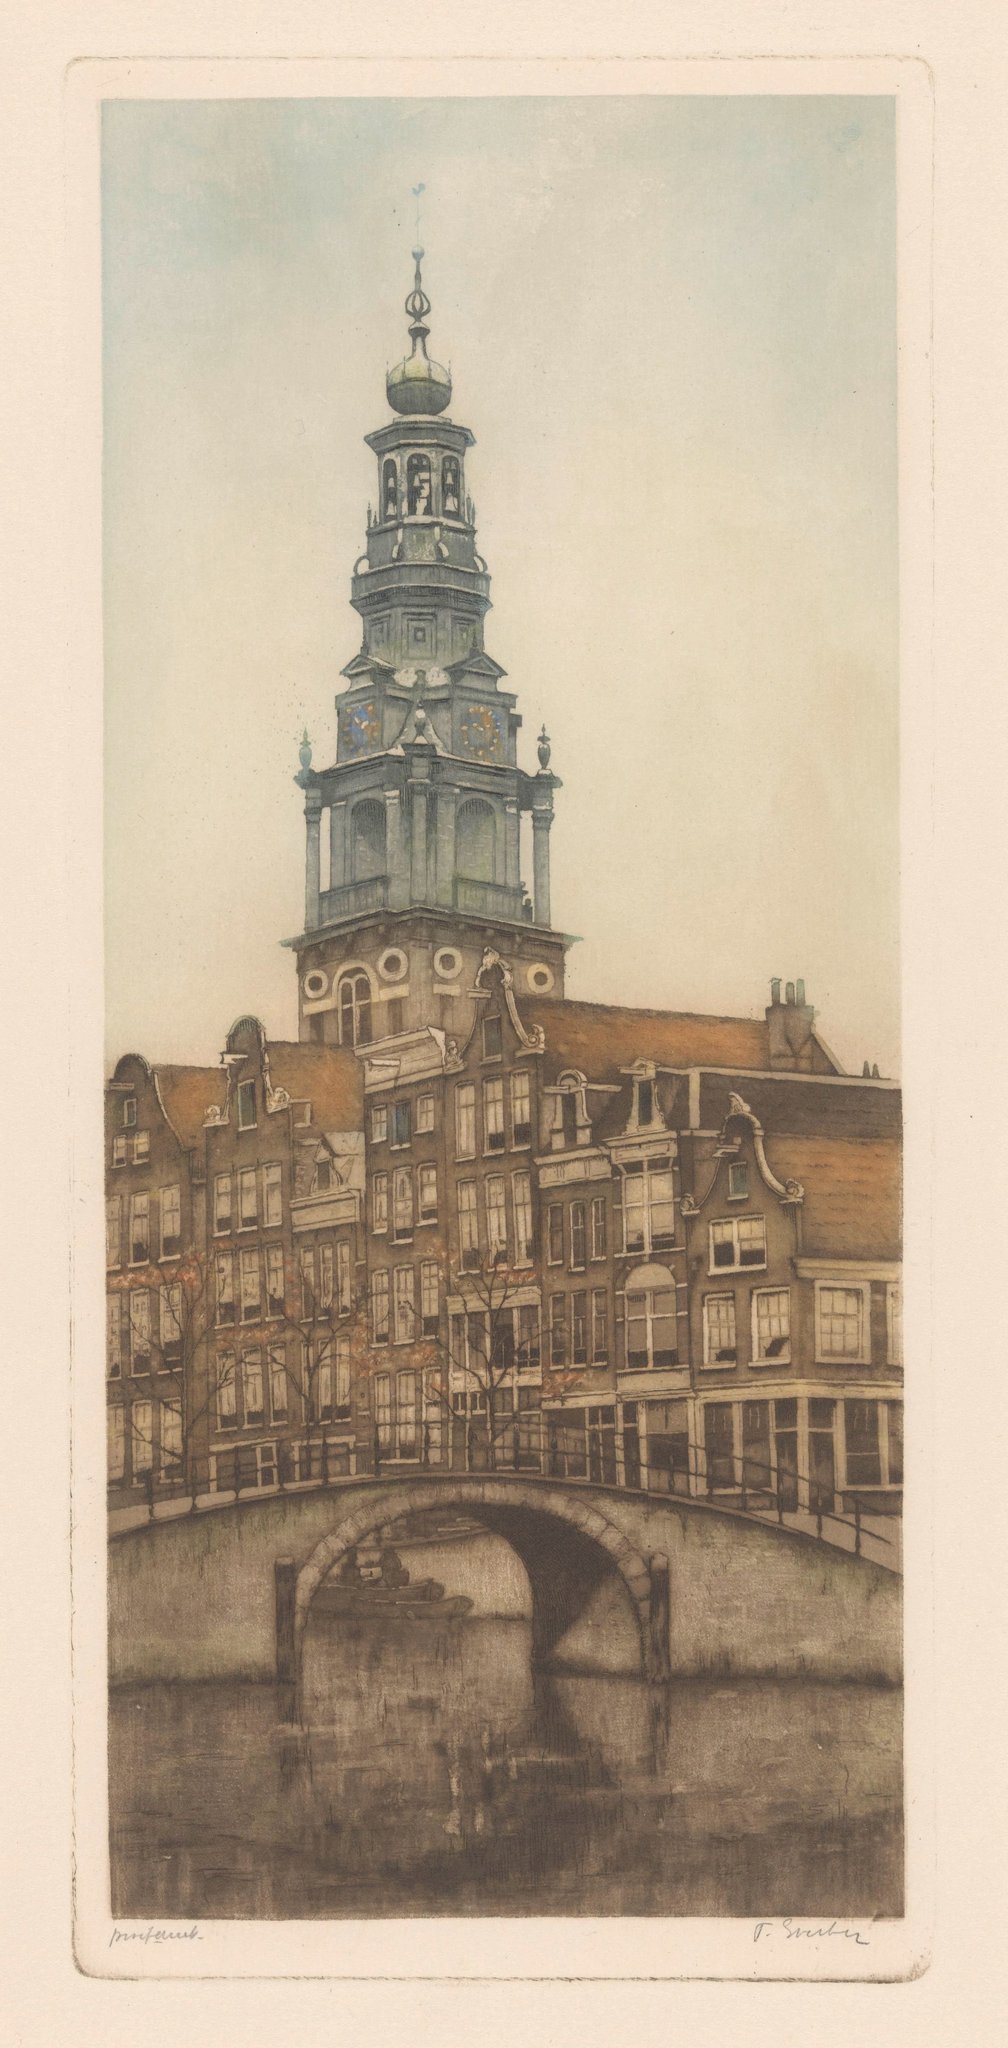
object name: print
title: Zuiderkerk in Amsterdam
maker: frans everbag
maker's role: draughtsman, print maker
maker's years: 1877-1947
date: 1887-1931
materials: paper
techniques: aquatint, etching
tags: canals, waters (in city), parts of church exterior and annexes: tower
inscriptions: collector's mark: Lugt 2228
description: De toren van de Zuiderkerk, gezien vanaf de Kloveniersburgwal in Amsterdam.